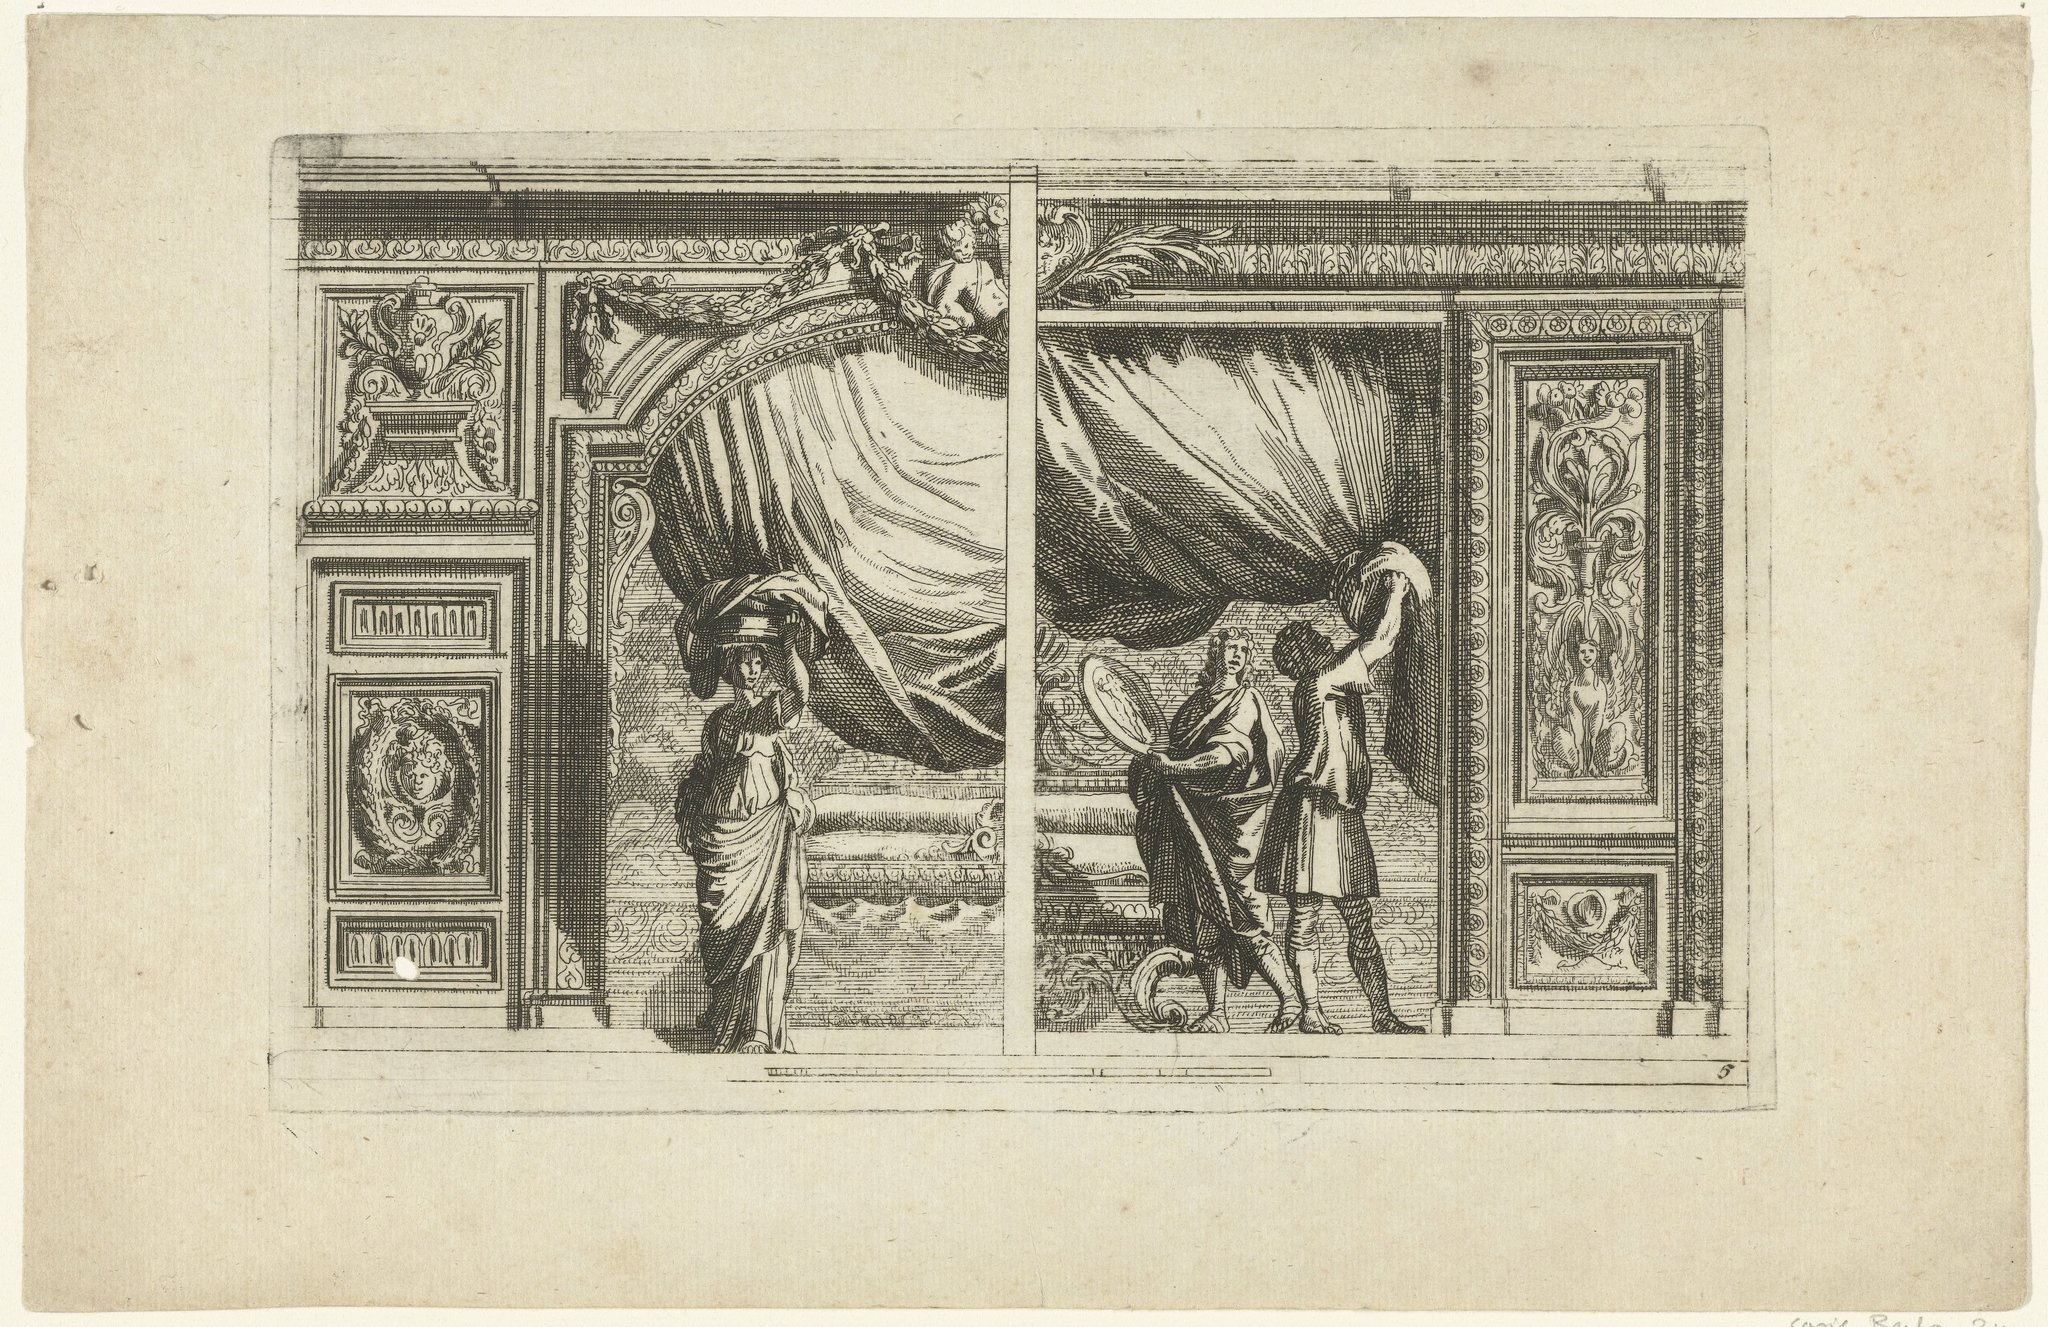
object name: print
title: Alkoven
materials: paper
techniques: etching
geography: amsterdam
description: Links staat een bediende met een mand met wasgoed op haar hoofd.